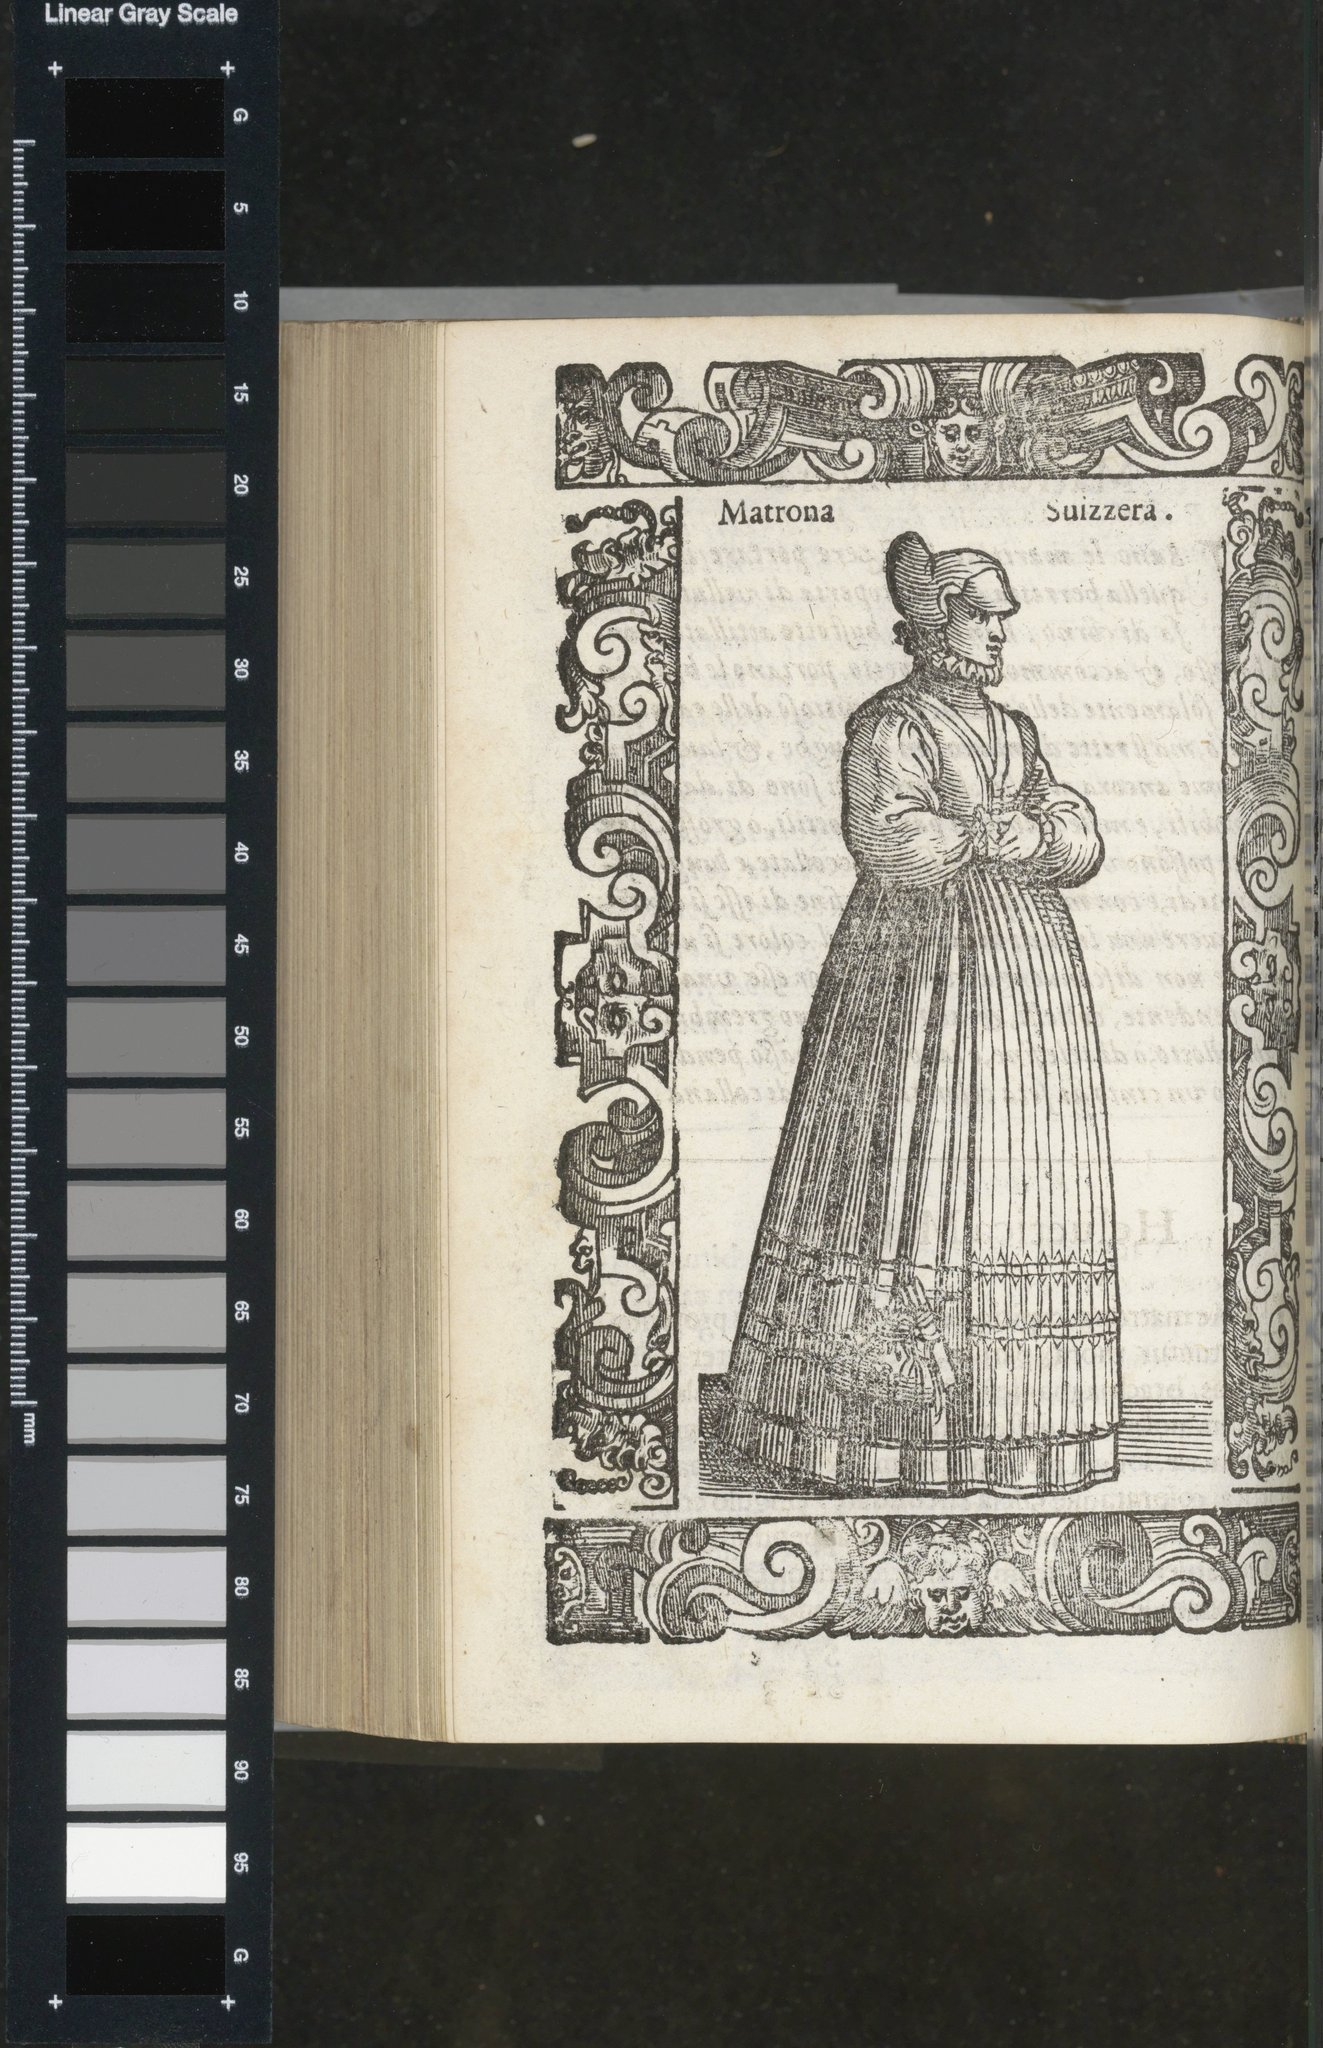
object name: costume print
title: Matrona Suizzera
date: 1598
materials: paper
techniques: woodcut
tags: fashion plates